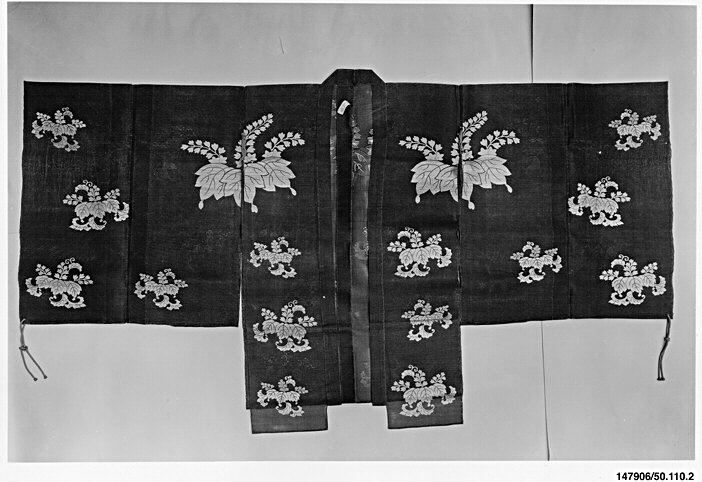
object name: noh costume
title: Noh Costume (Chōken) with Paulownia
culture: japanese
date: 1701-1800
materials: textile, metal thread, silk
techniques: brocade